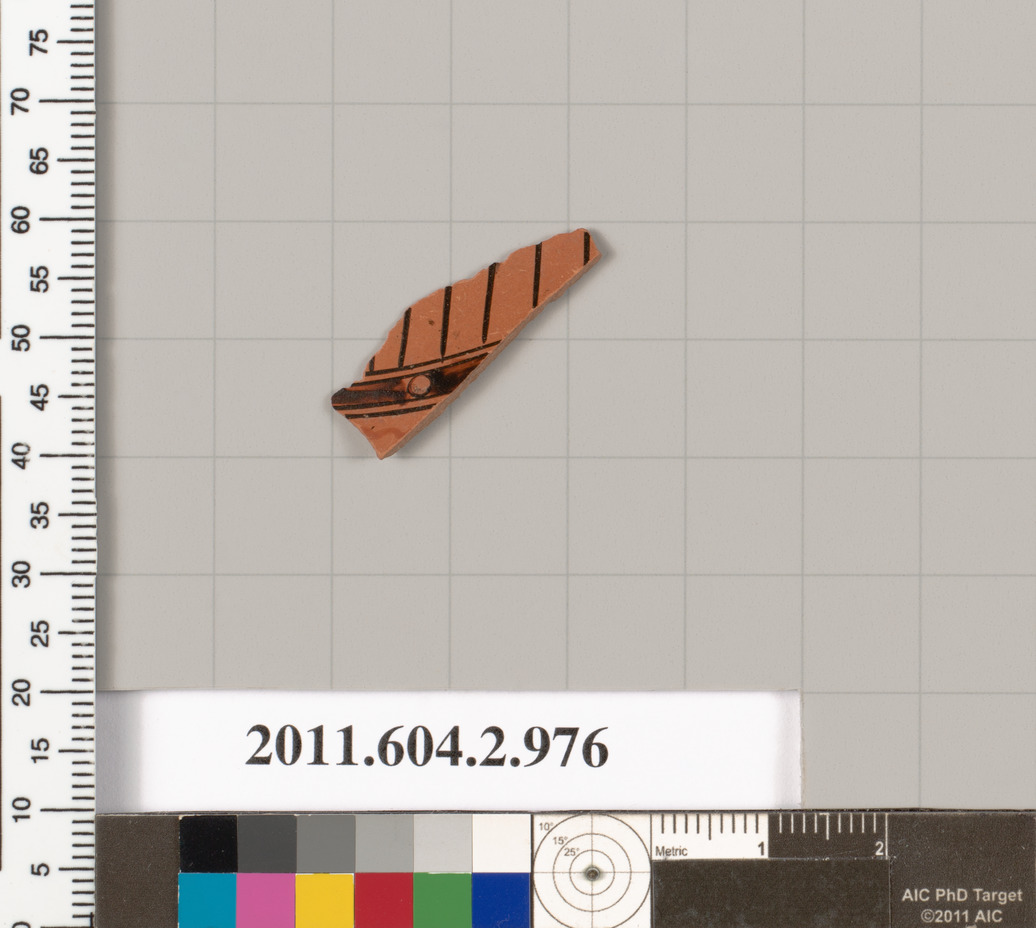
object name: oinochoe fragment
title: Terracotta fragment of an oinochoe (jug)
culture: greek, attic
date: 475-451 BCE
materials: terracotta